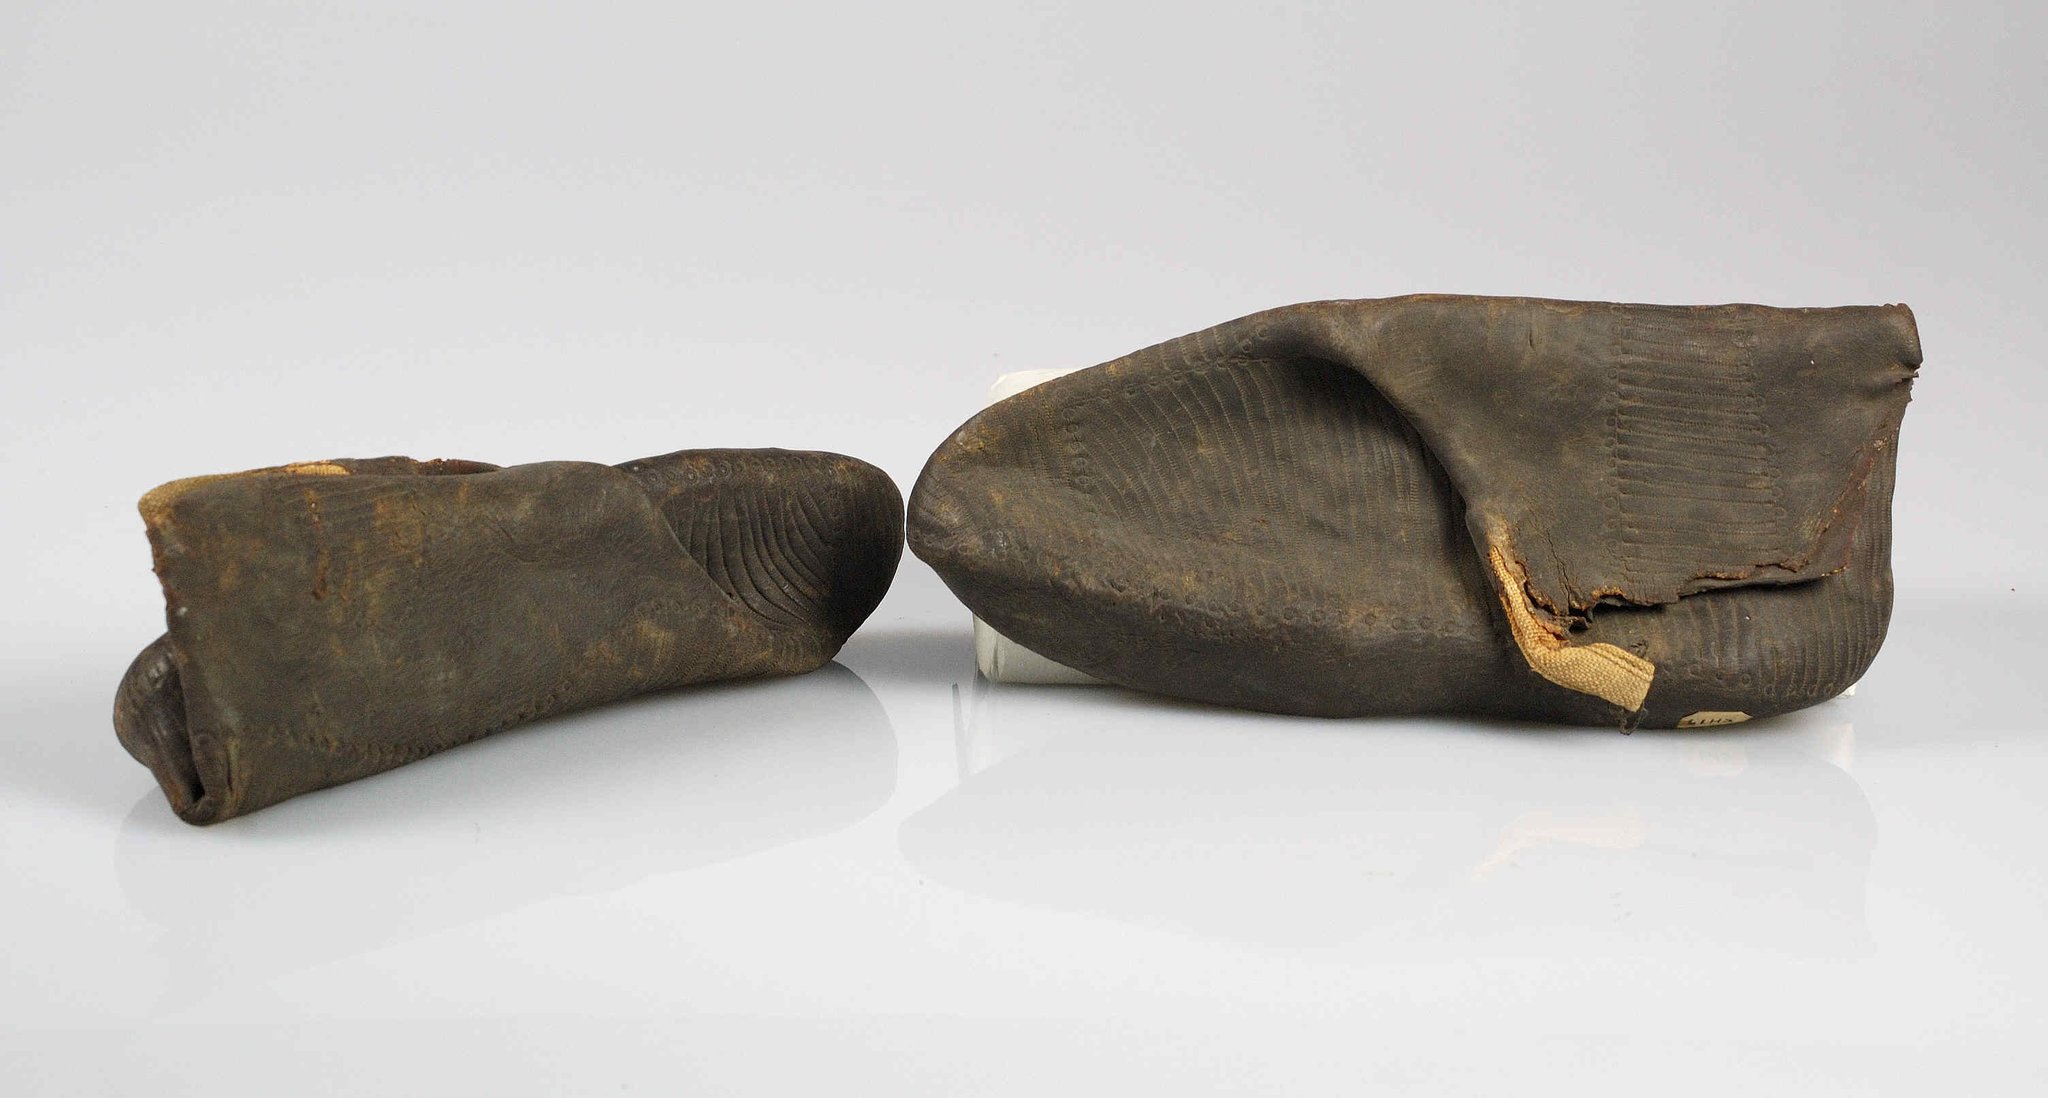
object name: galosh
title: Galoshes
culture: central american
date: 1830-1849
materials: cotton, rubber